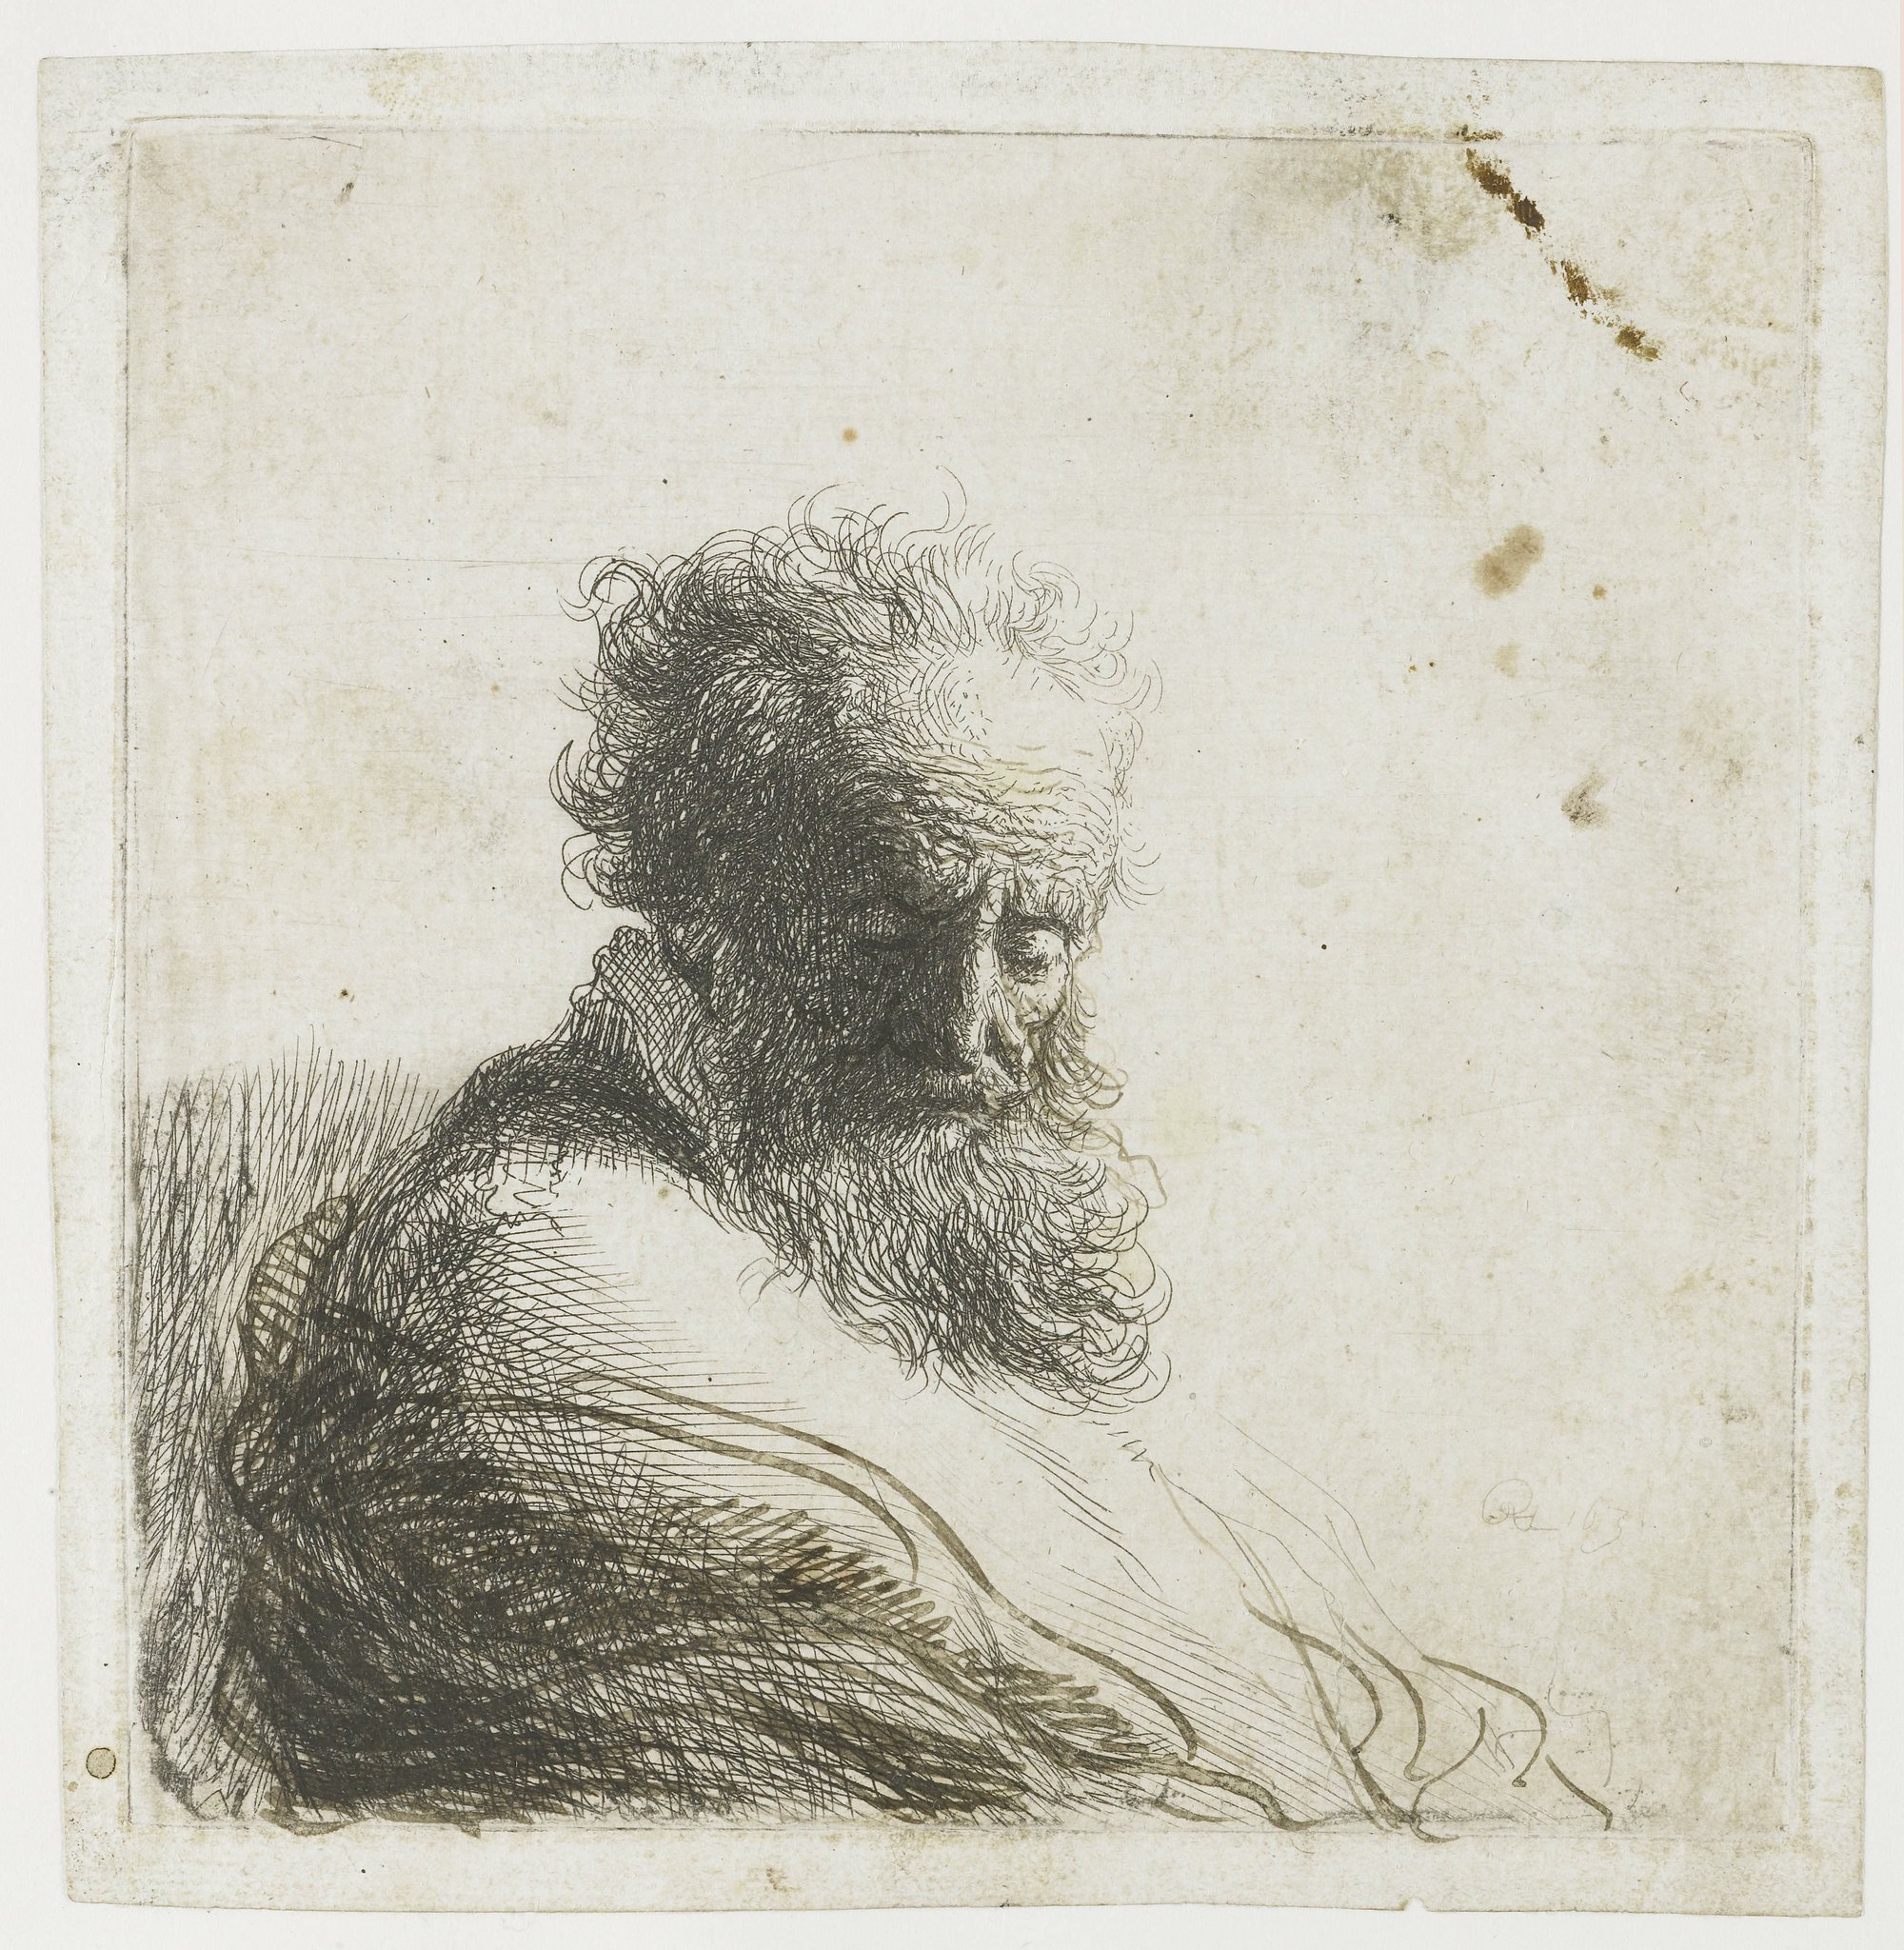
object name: print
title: Bust of an old bearded man, looking down, three quarters right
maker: rembrandt van rijn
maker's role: draughtsman, painter, print maker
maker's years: 1606-1669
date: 1631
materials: ink, paper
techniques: etching, pen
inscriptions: mark: Lugt 2228, monogram and date: ‘RHL 1631’